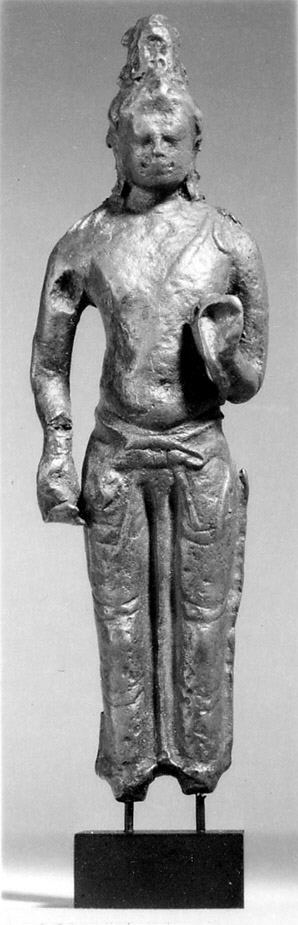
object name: figure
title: Standing Avalokiteshvara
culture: indonesian, sumatran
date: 901-1100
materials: bronze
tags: buddhism,avalokiteshvara,bodhisattvas